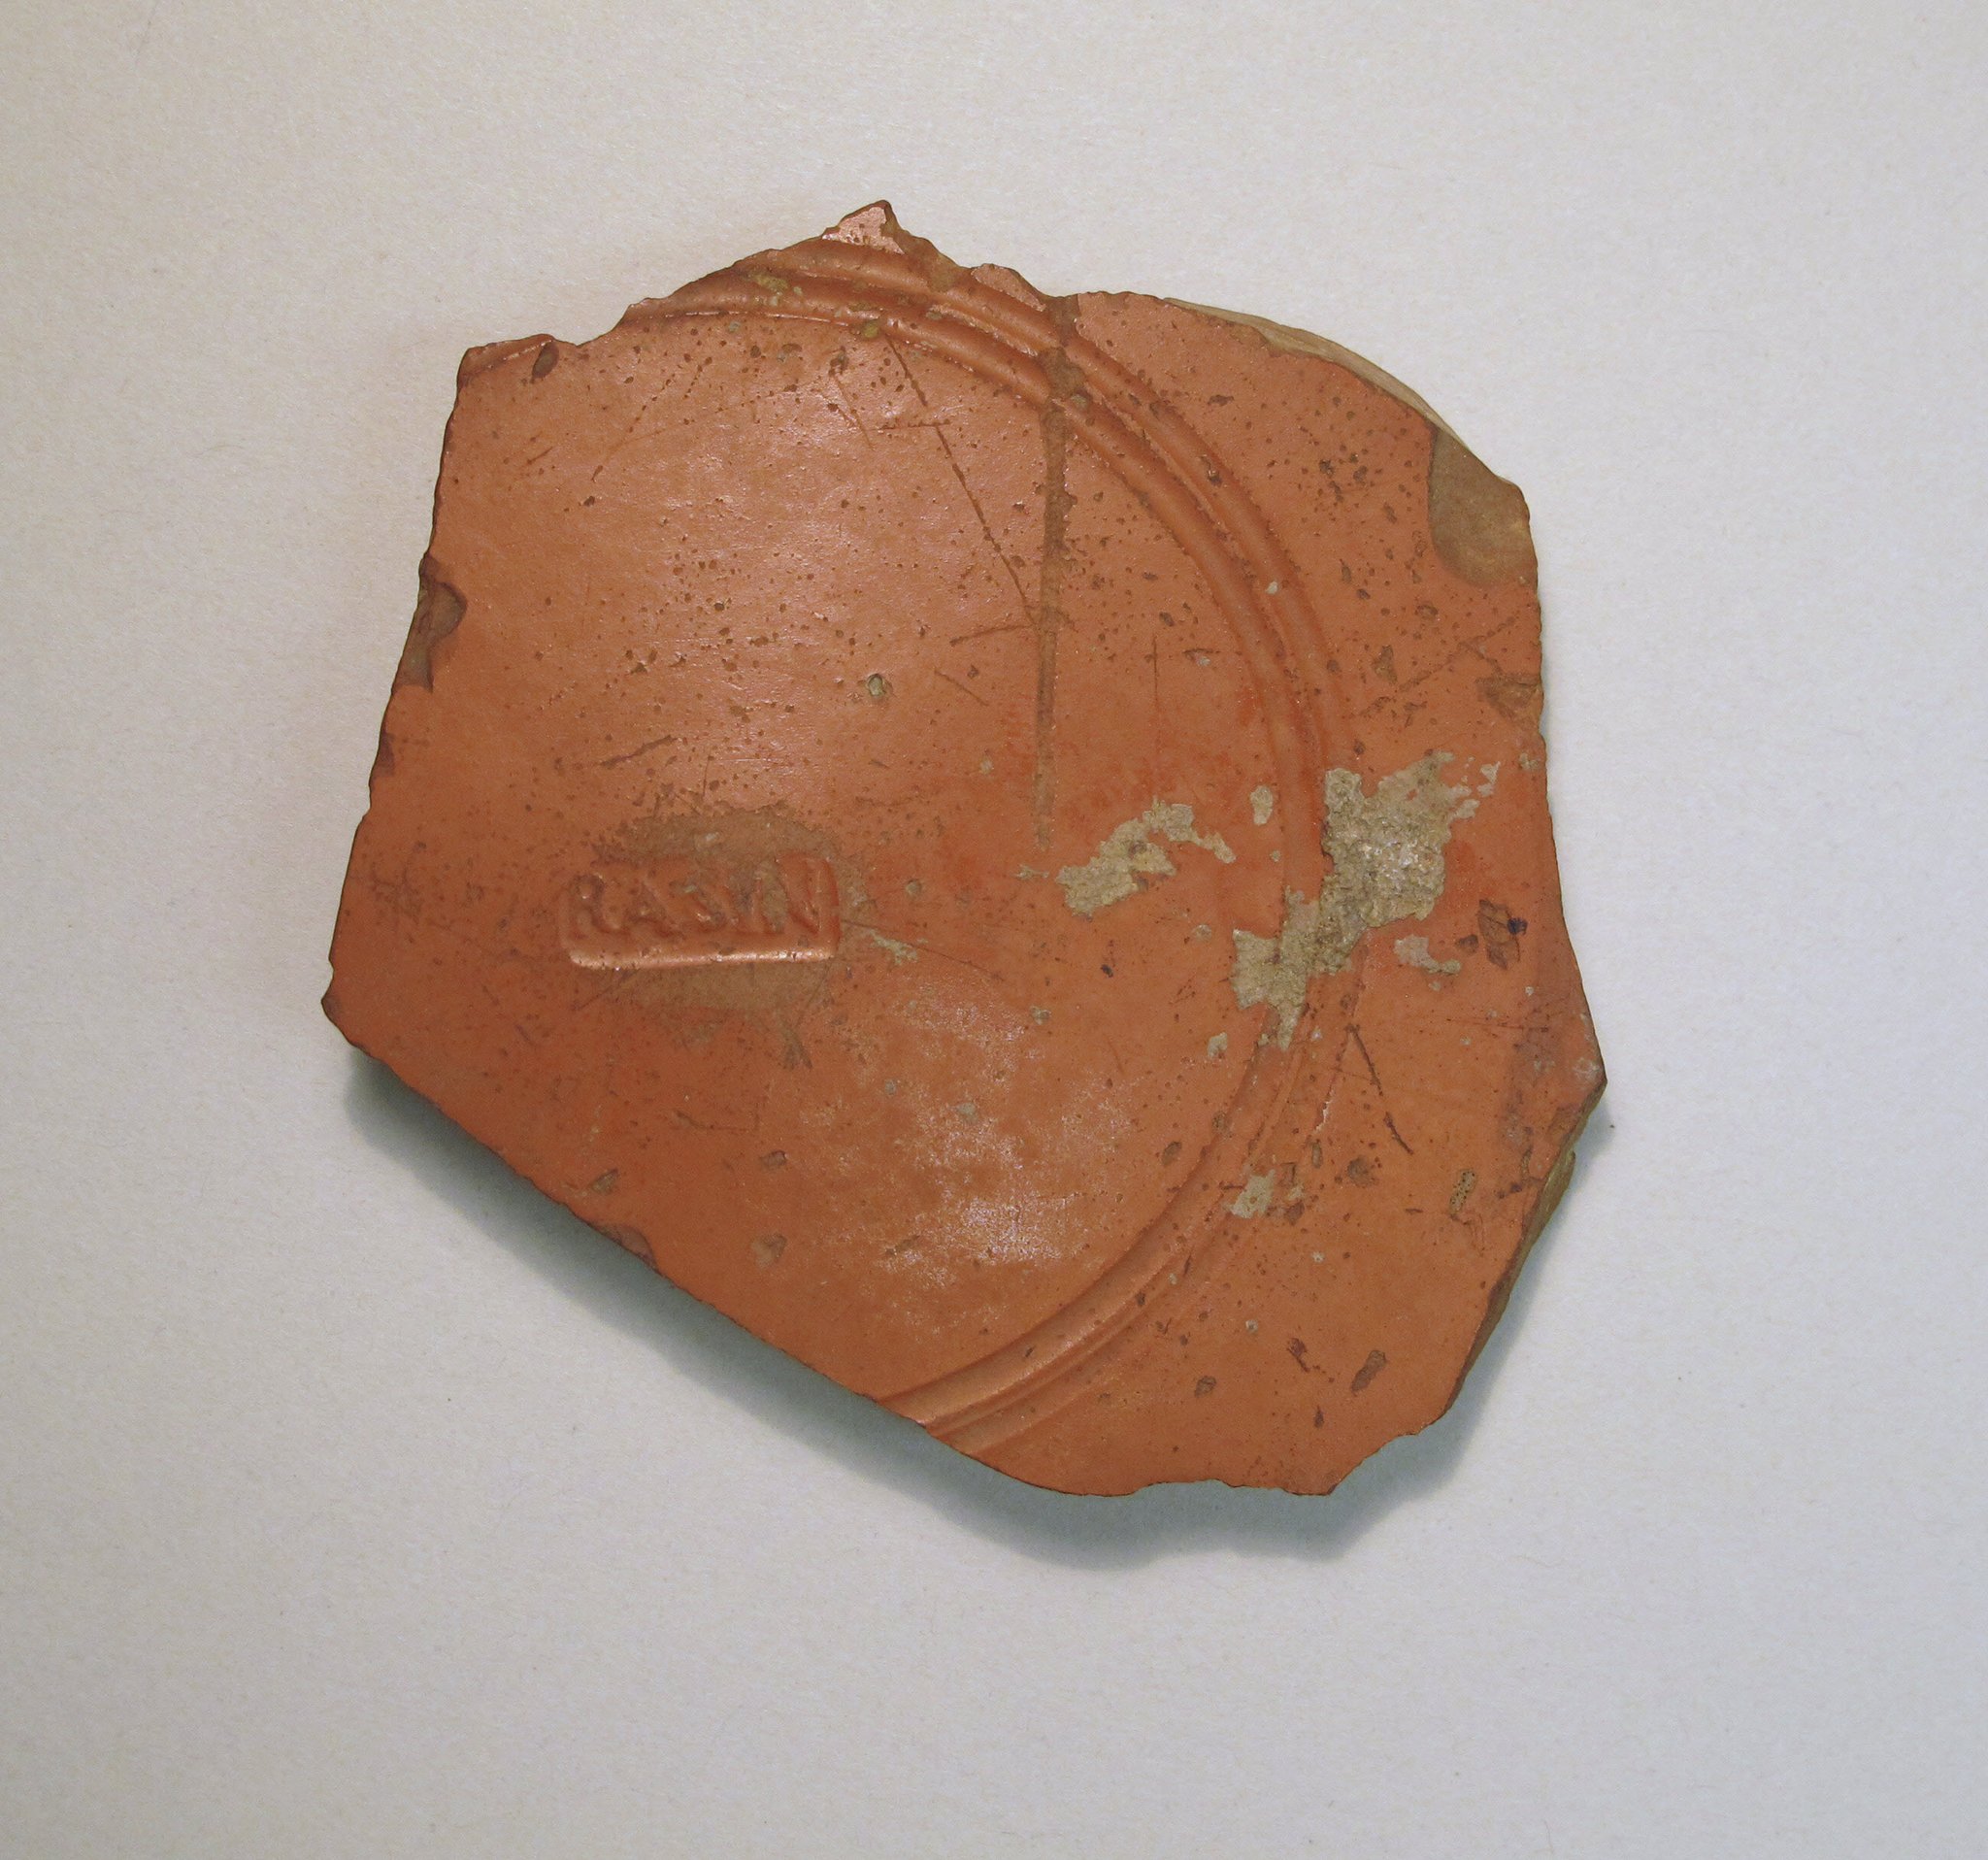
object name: vase fragment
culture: roman, gaul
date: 120 BCE-300 CE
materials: terracotta